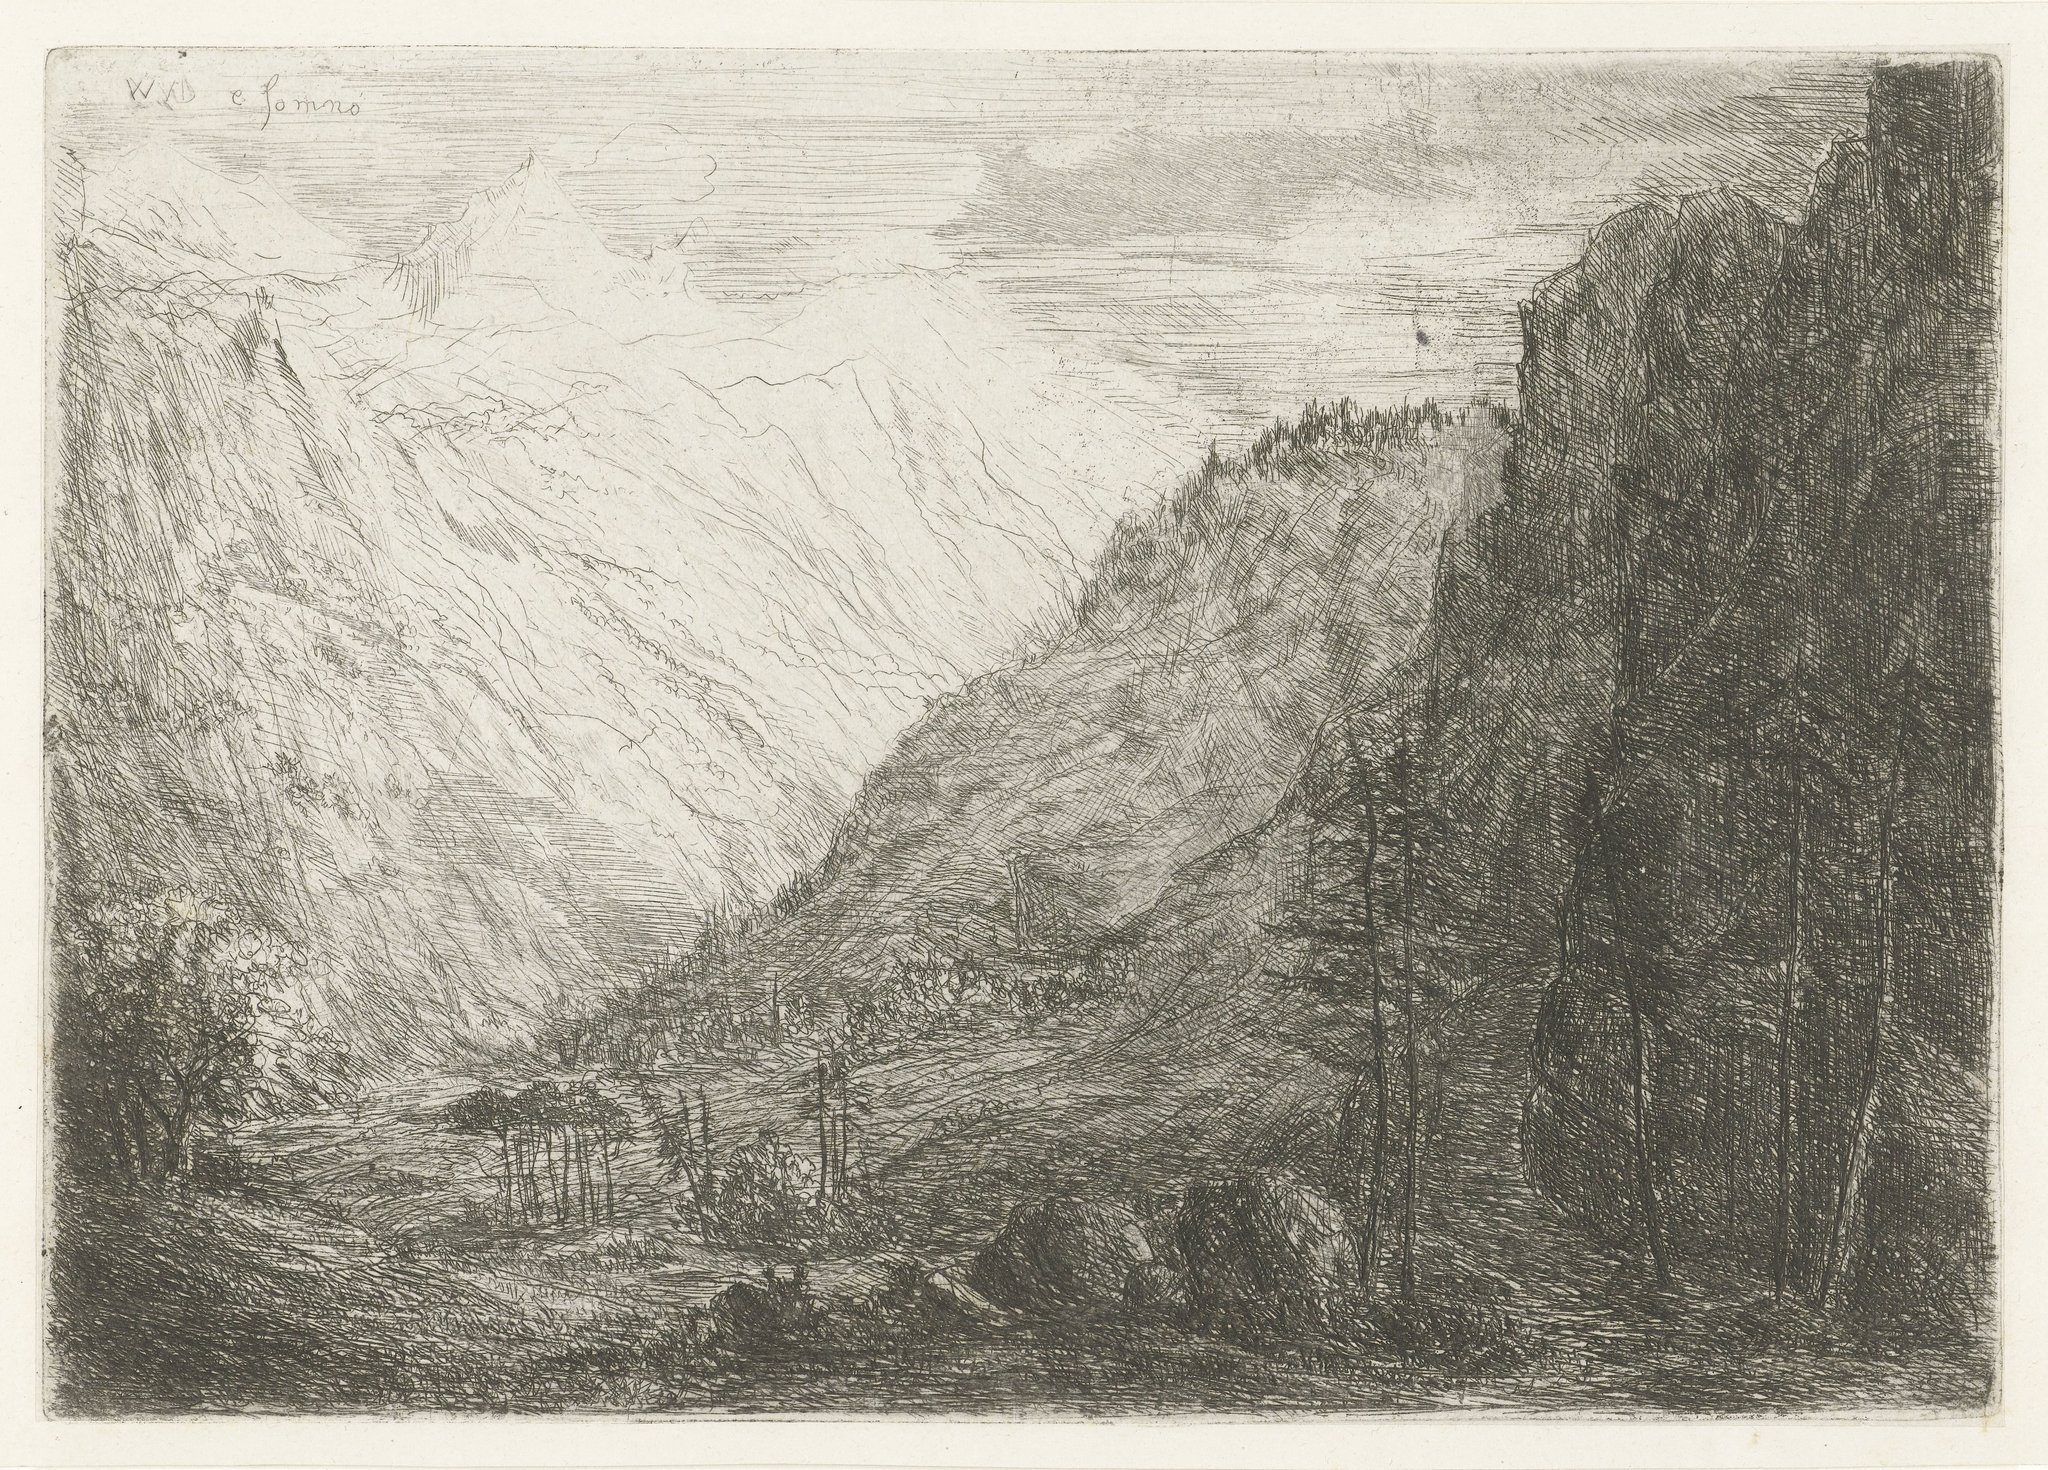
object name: print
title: Gezicht op bergdal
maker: willem matthias jan van dielen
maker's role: print maker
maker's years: 1805-1867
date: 1815-1867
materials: paper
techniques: etching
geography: netherlands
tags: dale, valley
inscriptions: collector's mark: Lugt 2228